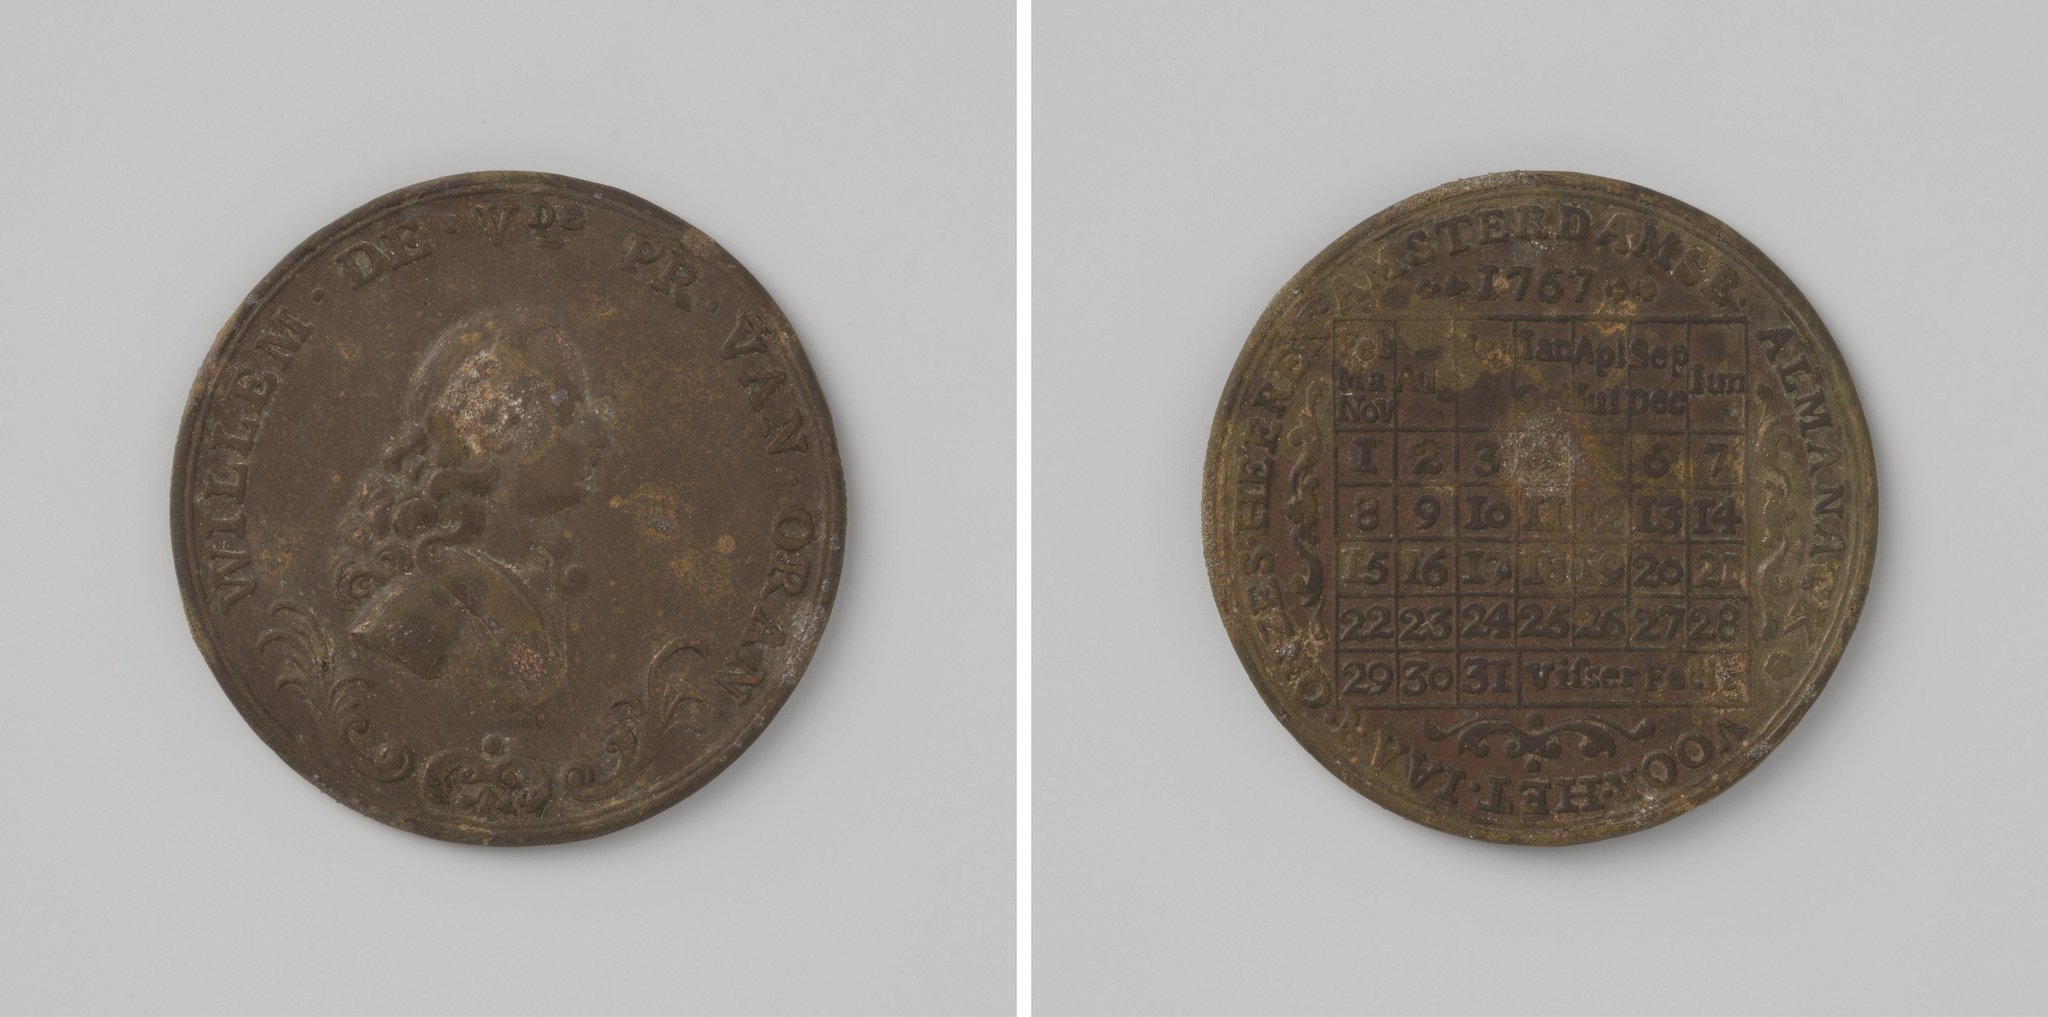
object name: copy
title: Amsterdamse almanak voor het jaar 1767, ter ere van Willem V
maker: visser (rond 1767)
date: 1767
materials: alloy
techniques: striking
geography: netherlands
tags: the hague, william v (prince of orange), amsterdam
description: Penning. Voorzijde: borststuk jongeman binnen omschrift. Keerzijde: kalender onder jaartal binnen omschrift